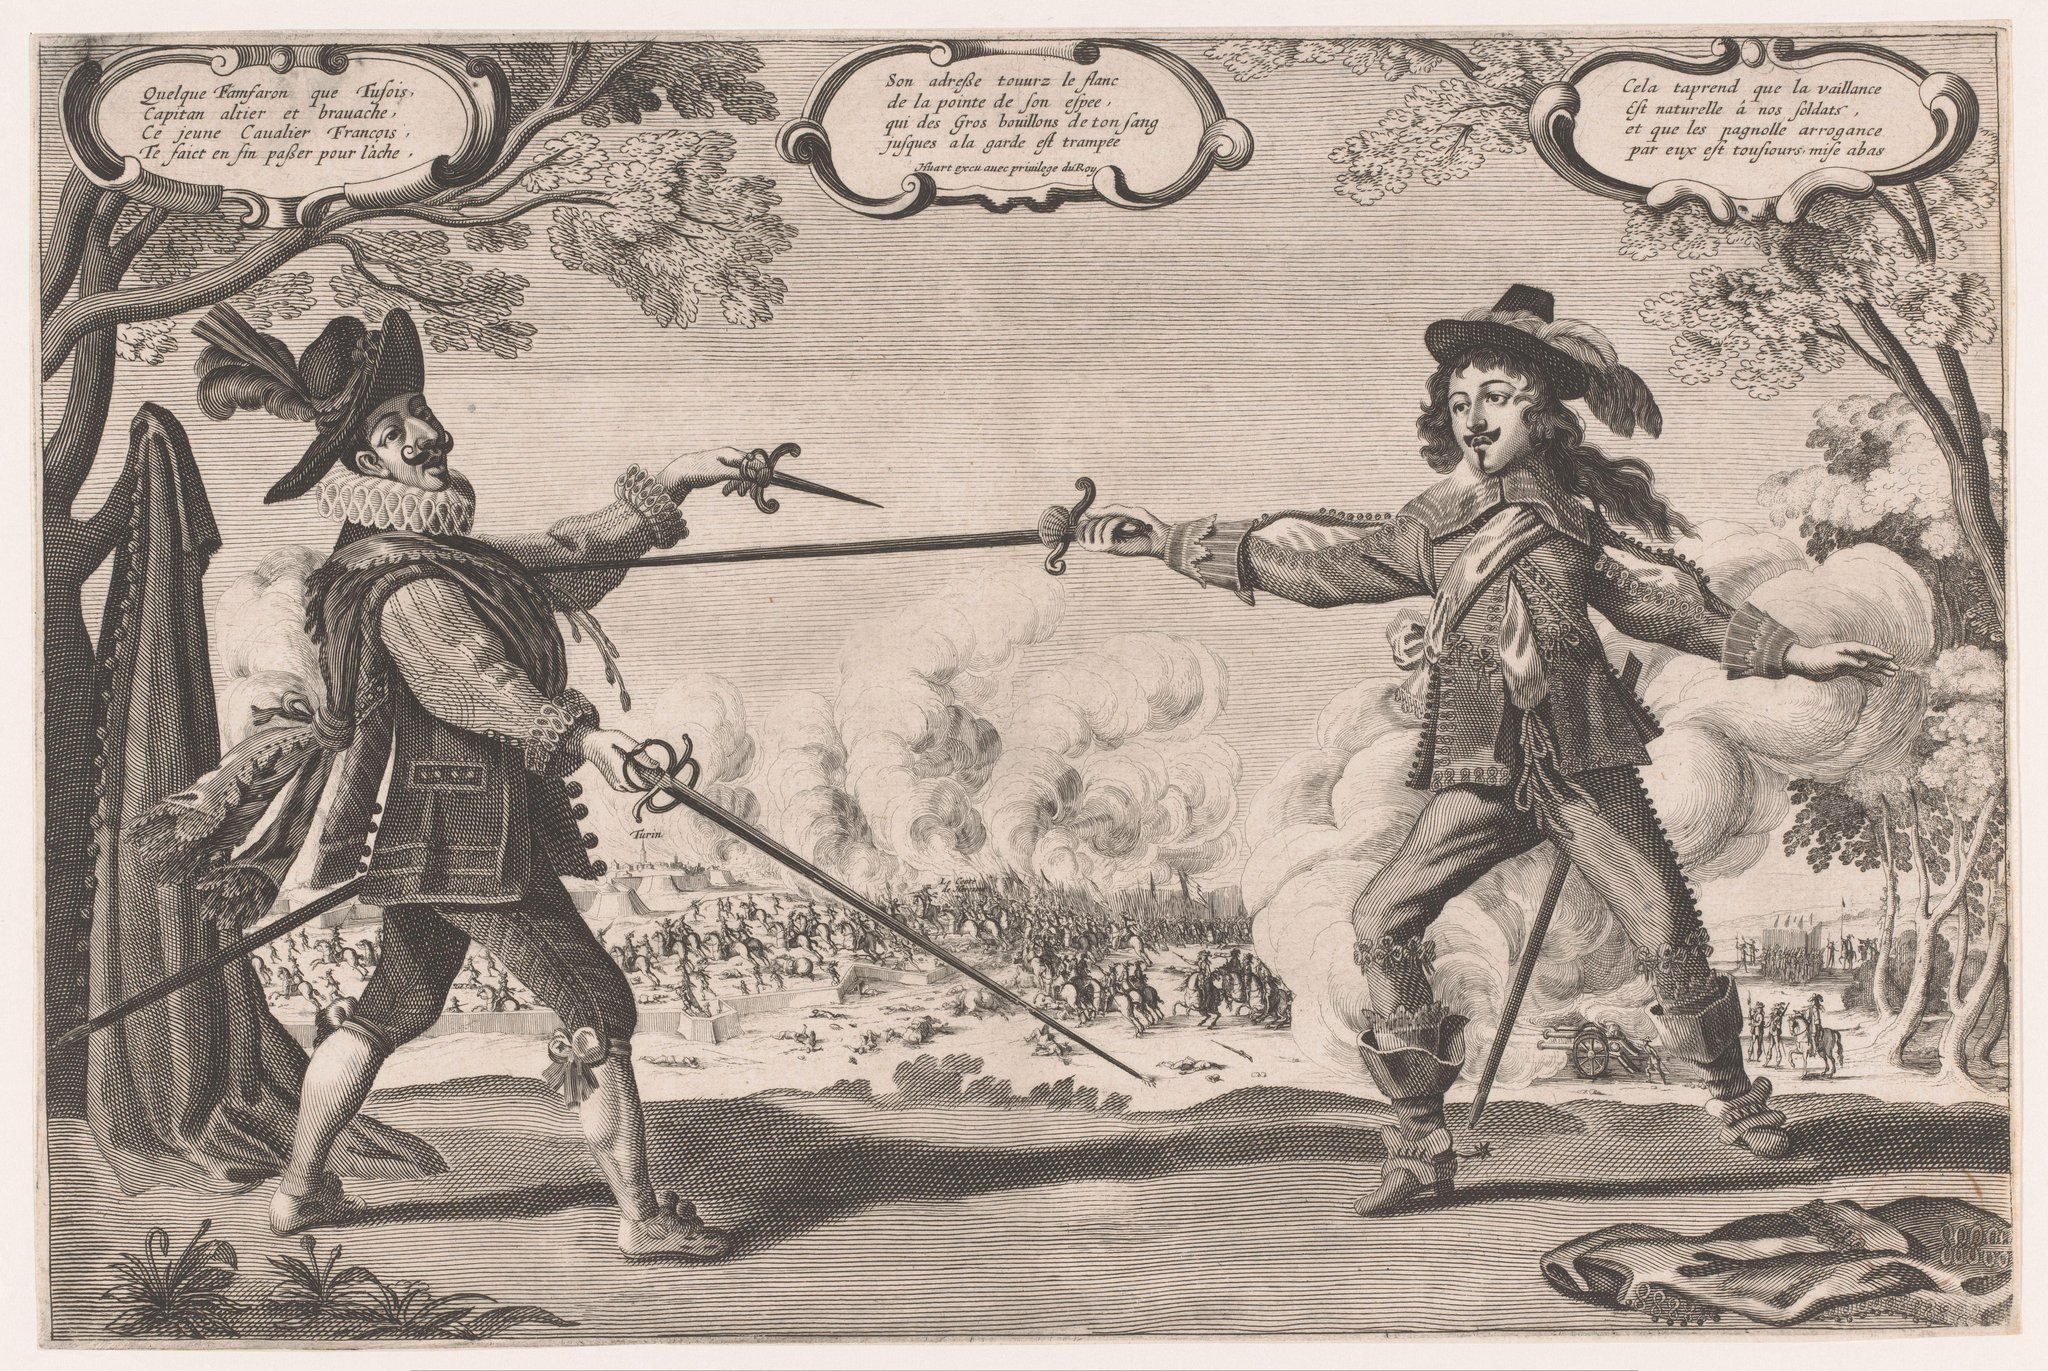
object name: print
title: Twee duellerende edellieden met degens op een slagveld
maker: Anonymous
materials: paper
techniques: engraving, etching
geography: france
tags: duel in place of battle, fencing (sport), hacking and thrusting weapons: rapier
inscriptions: collector's mark: Lugt 240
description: Twee edellieden kruisen de degens, met op de achtergrond strijdgewoel en links achterin de stad Turijn.